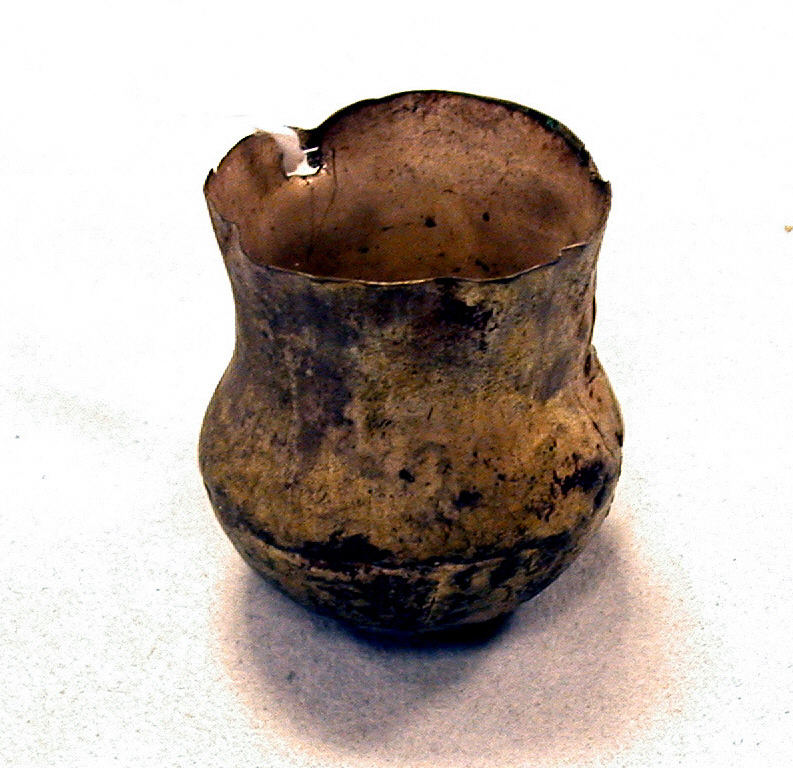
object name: ornament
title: Miniature Cup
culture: peruvian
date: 701-1566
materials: gilt, silver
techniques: hammering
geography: peru